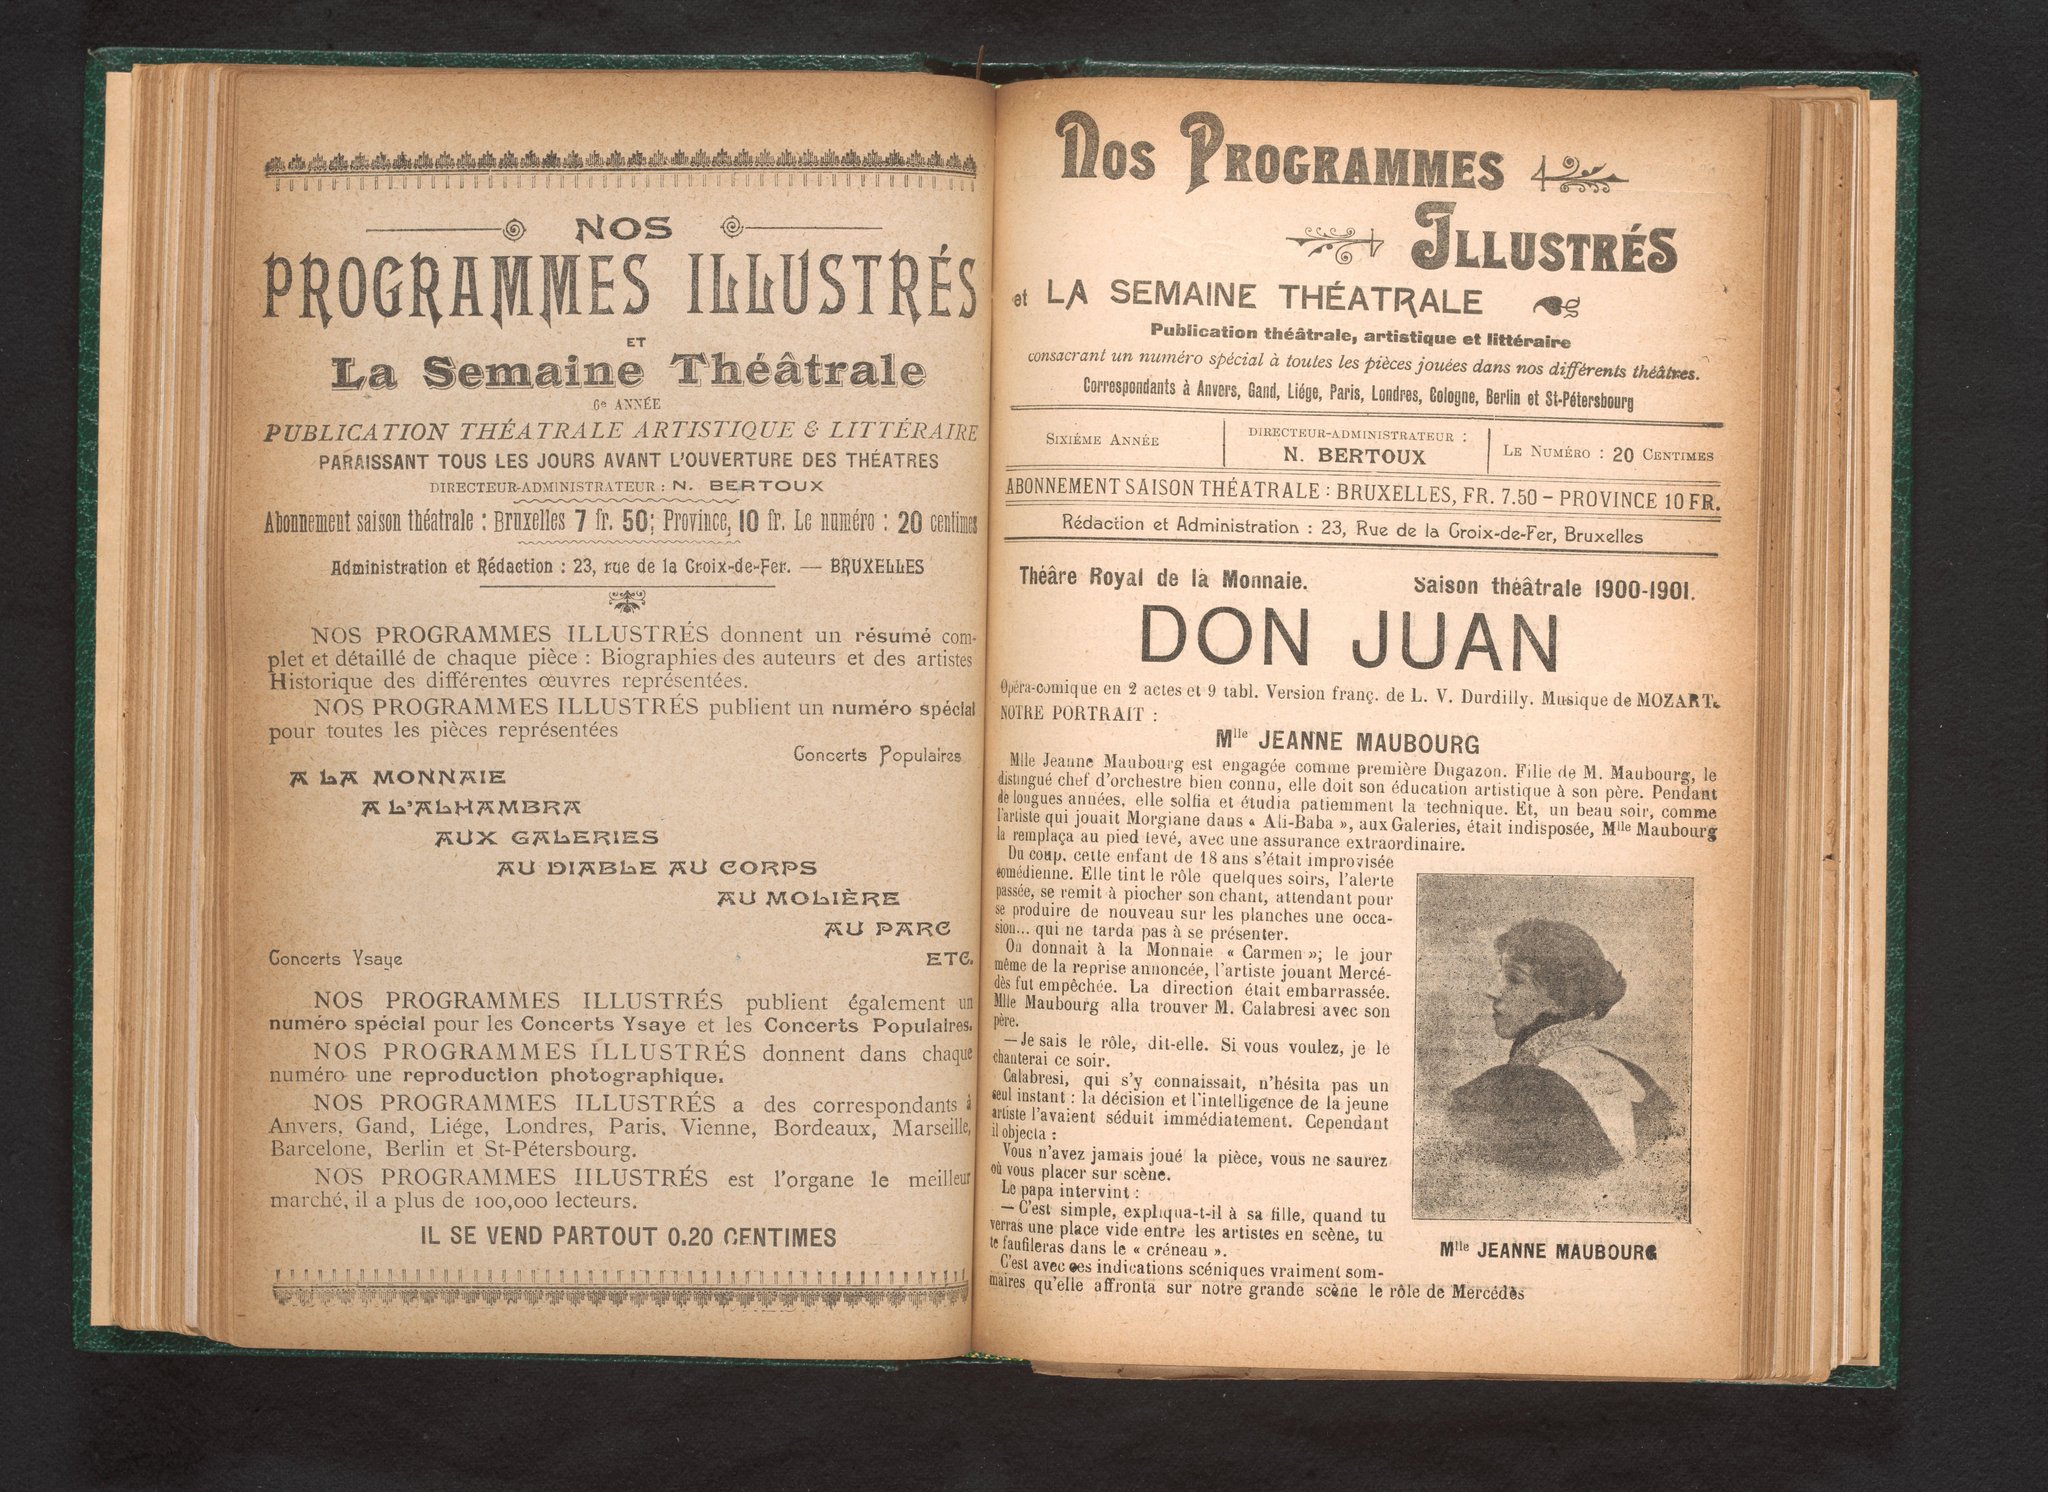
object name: page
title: Mlle Jeanne Maubourg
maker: Anonymous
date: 1895-1900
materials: paper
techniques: autotype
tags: adult woman, historical persons